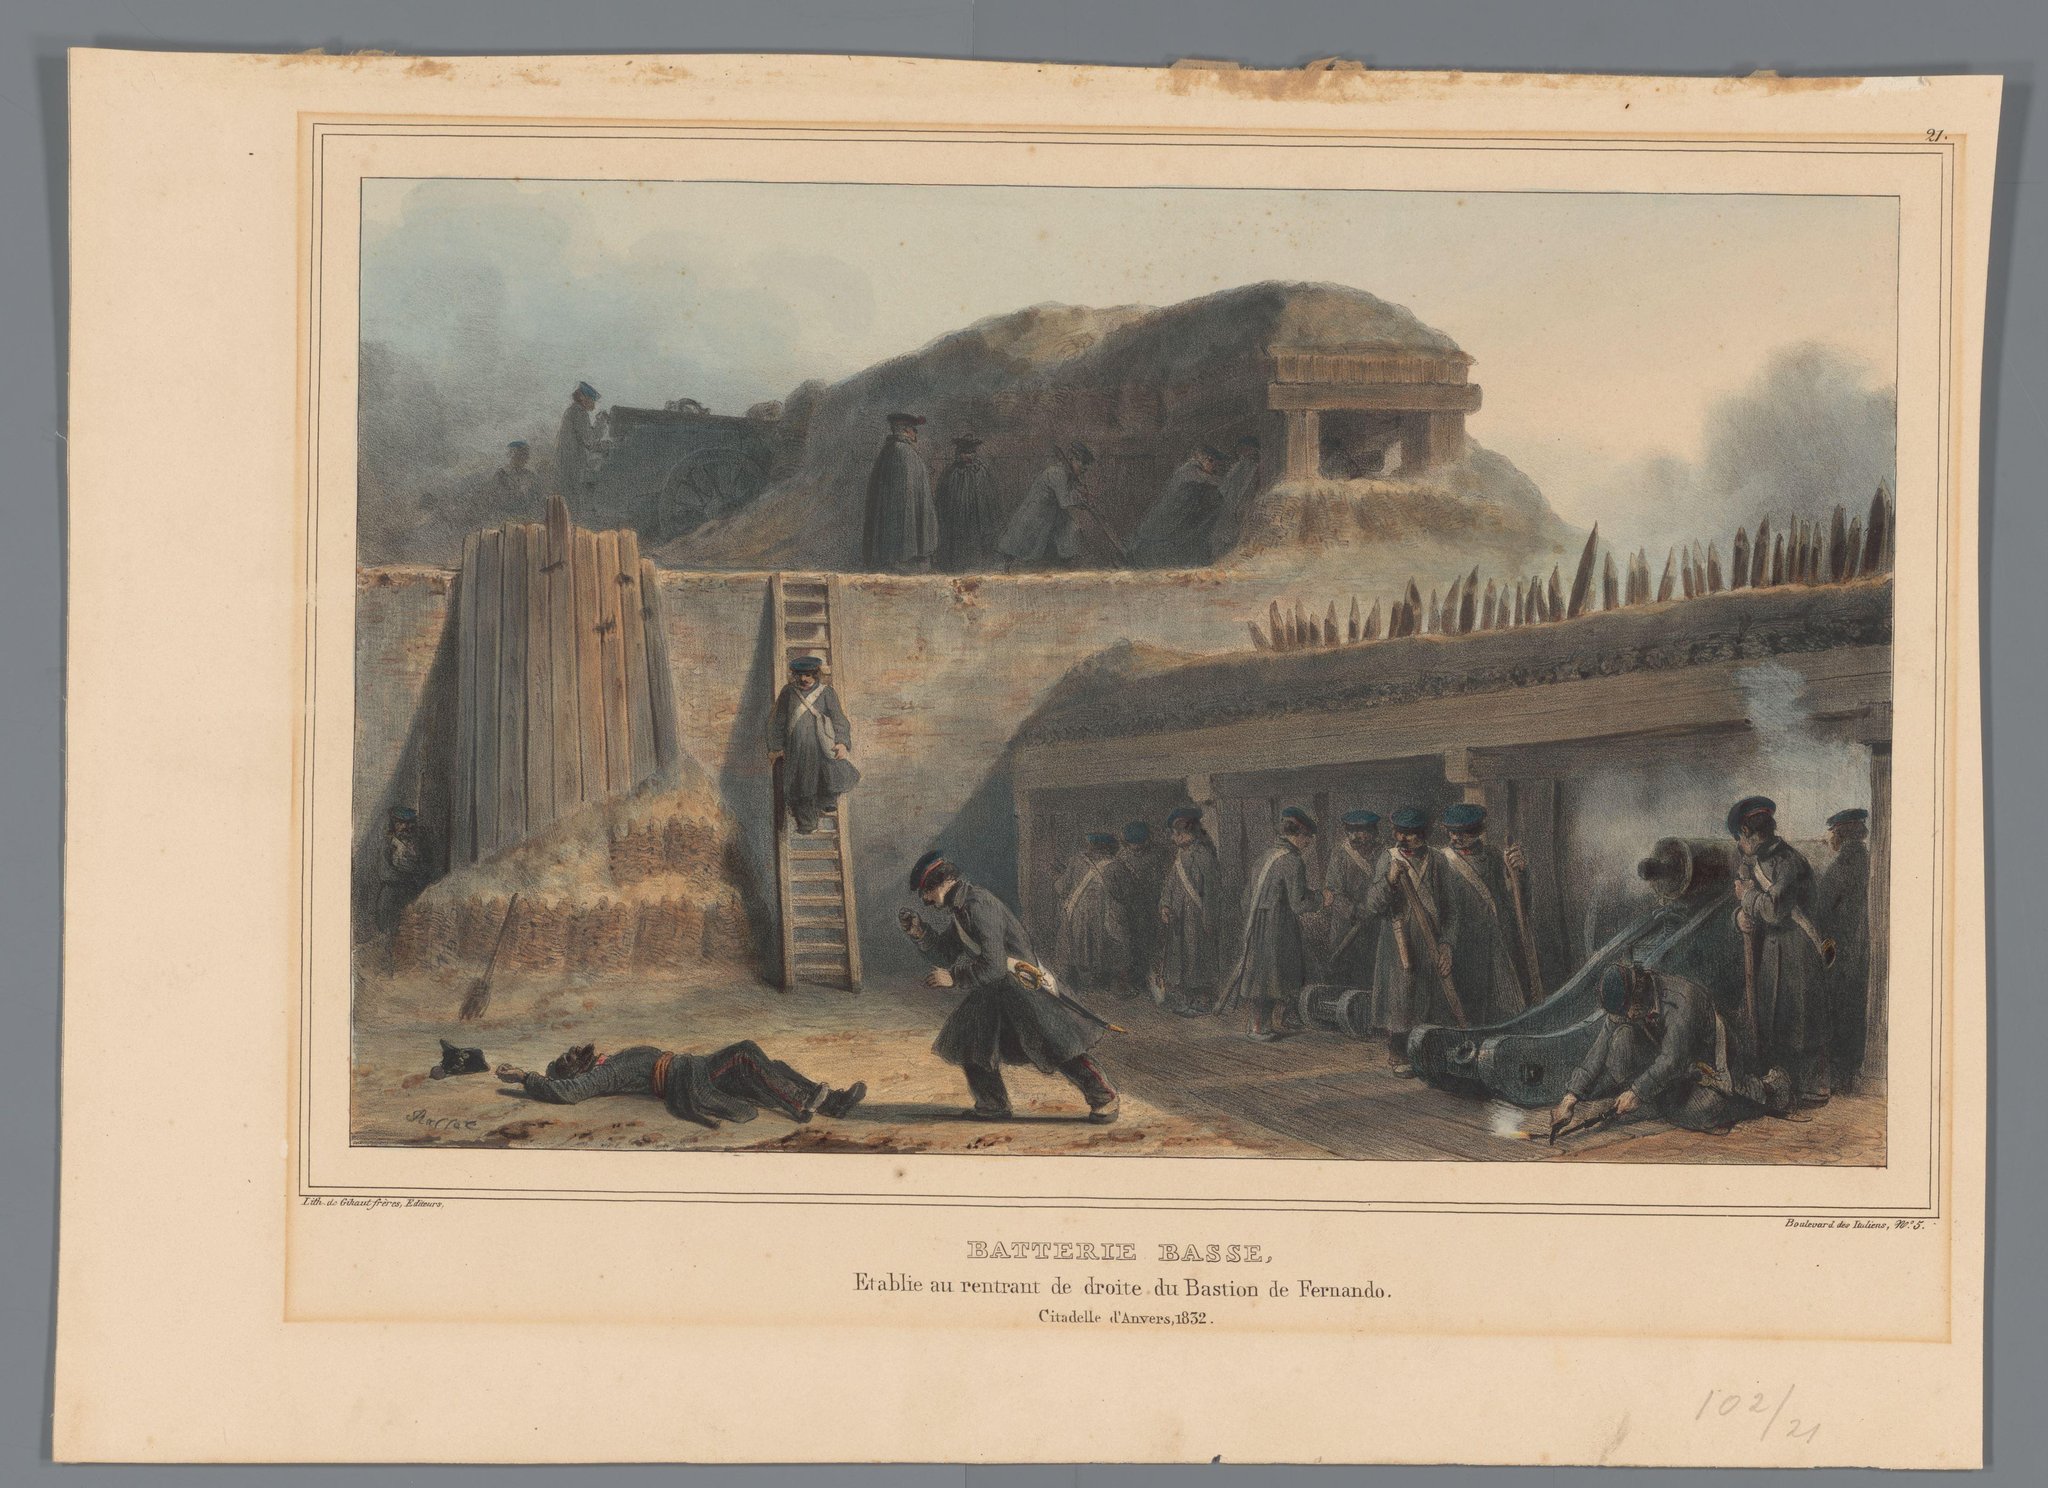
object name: print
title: Batterie Basse, établie au rentrant de droite du Bastion de Fernando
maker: denis auguste marie raffet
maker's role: draughtsman, print maker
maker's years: 1804-1860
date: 1833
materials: lacquer, paper, watercolor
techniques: hand coloring, lacquer, lithograph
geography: paris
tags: fortifications, military engineering, firearms: cannon, antwerp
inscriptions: caption: ‘BATTERIE BASSE, / Etablie au rentrant de droite du Bastion de Fernando. / Citadelle d'Anvers, 1832.’, signature: ‘Raffet’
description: Soldaten bezig bij een rij kanonnen; links op de voorgrond ligt een gewonde. Onderdeel van de serie van 24 prenten over het beleg van de Citadel van Antwerpen, 30 november - 23 december 1832.